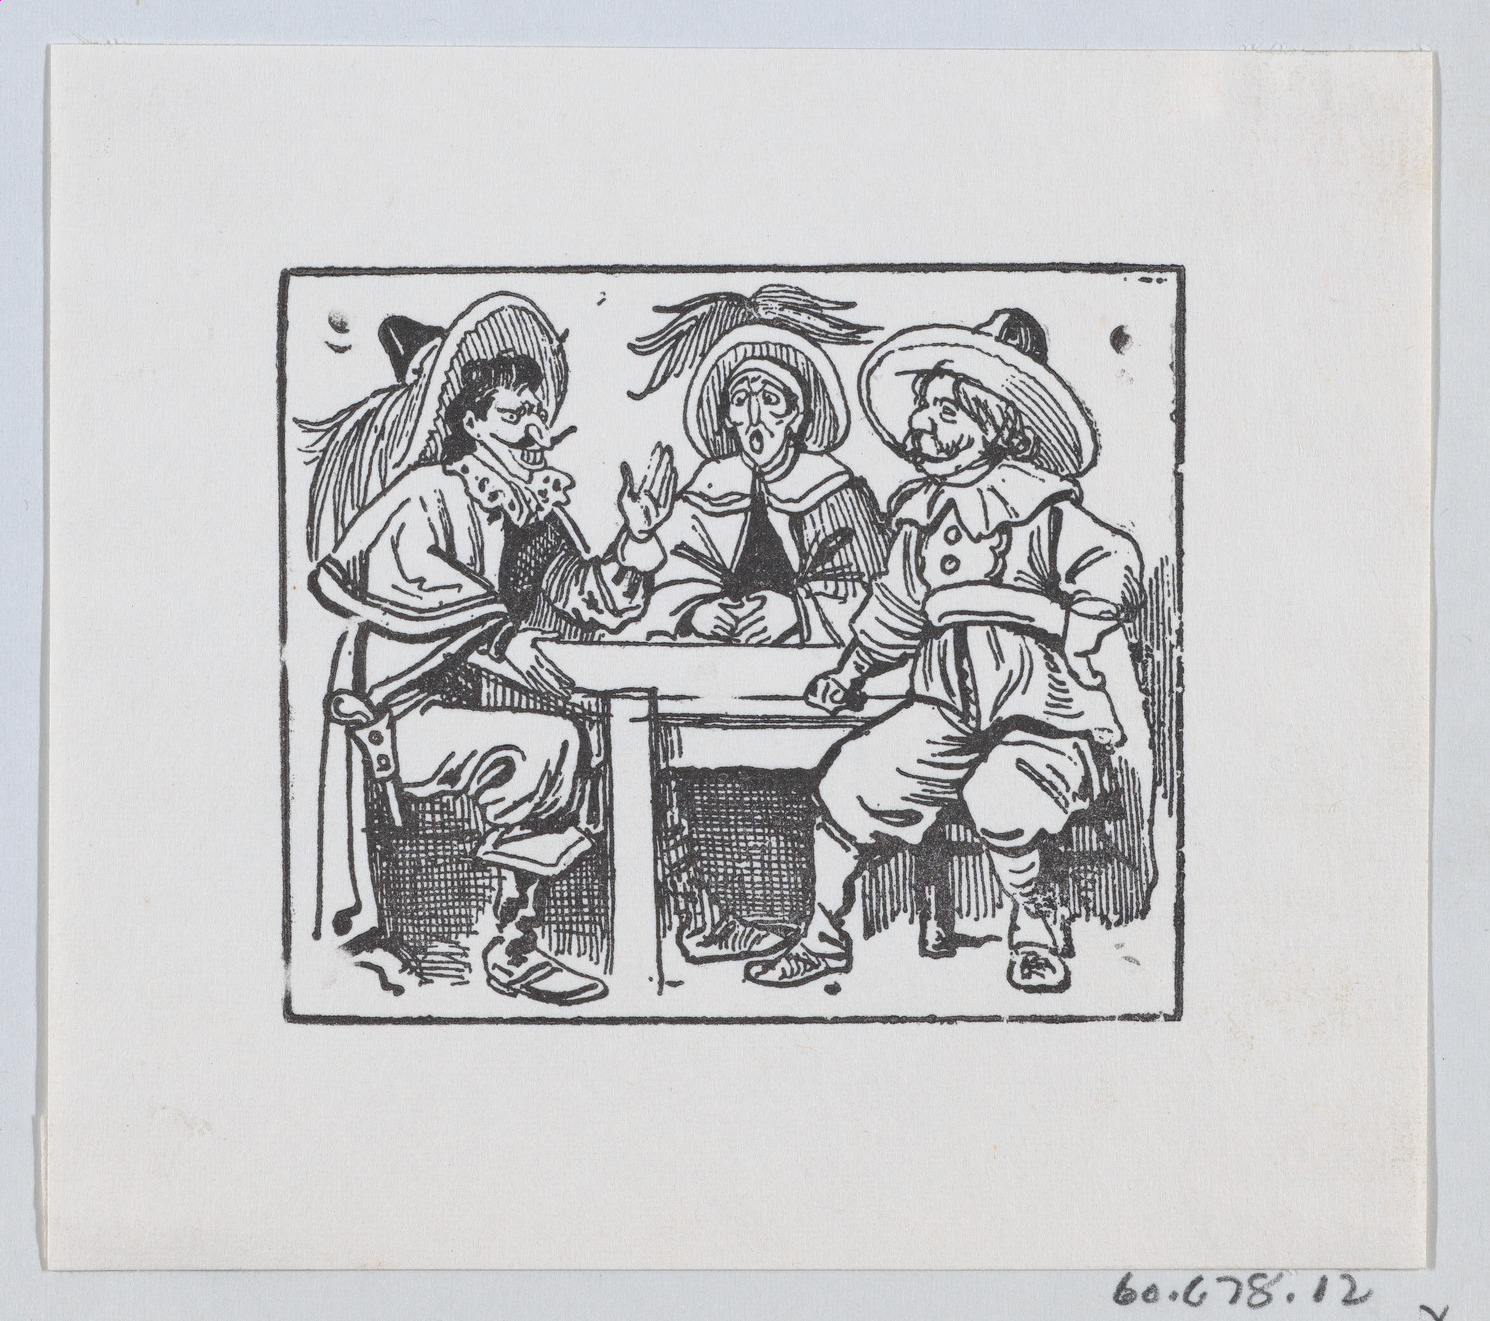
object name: print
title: Three men wearing large hats and capes sitting at a table and talking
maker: josé guadalupe posada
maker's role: artist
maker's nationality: mexican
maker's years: 1852-1913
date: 1880-1910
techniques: lithography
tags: hats,men